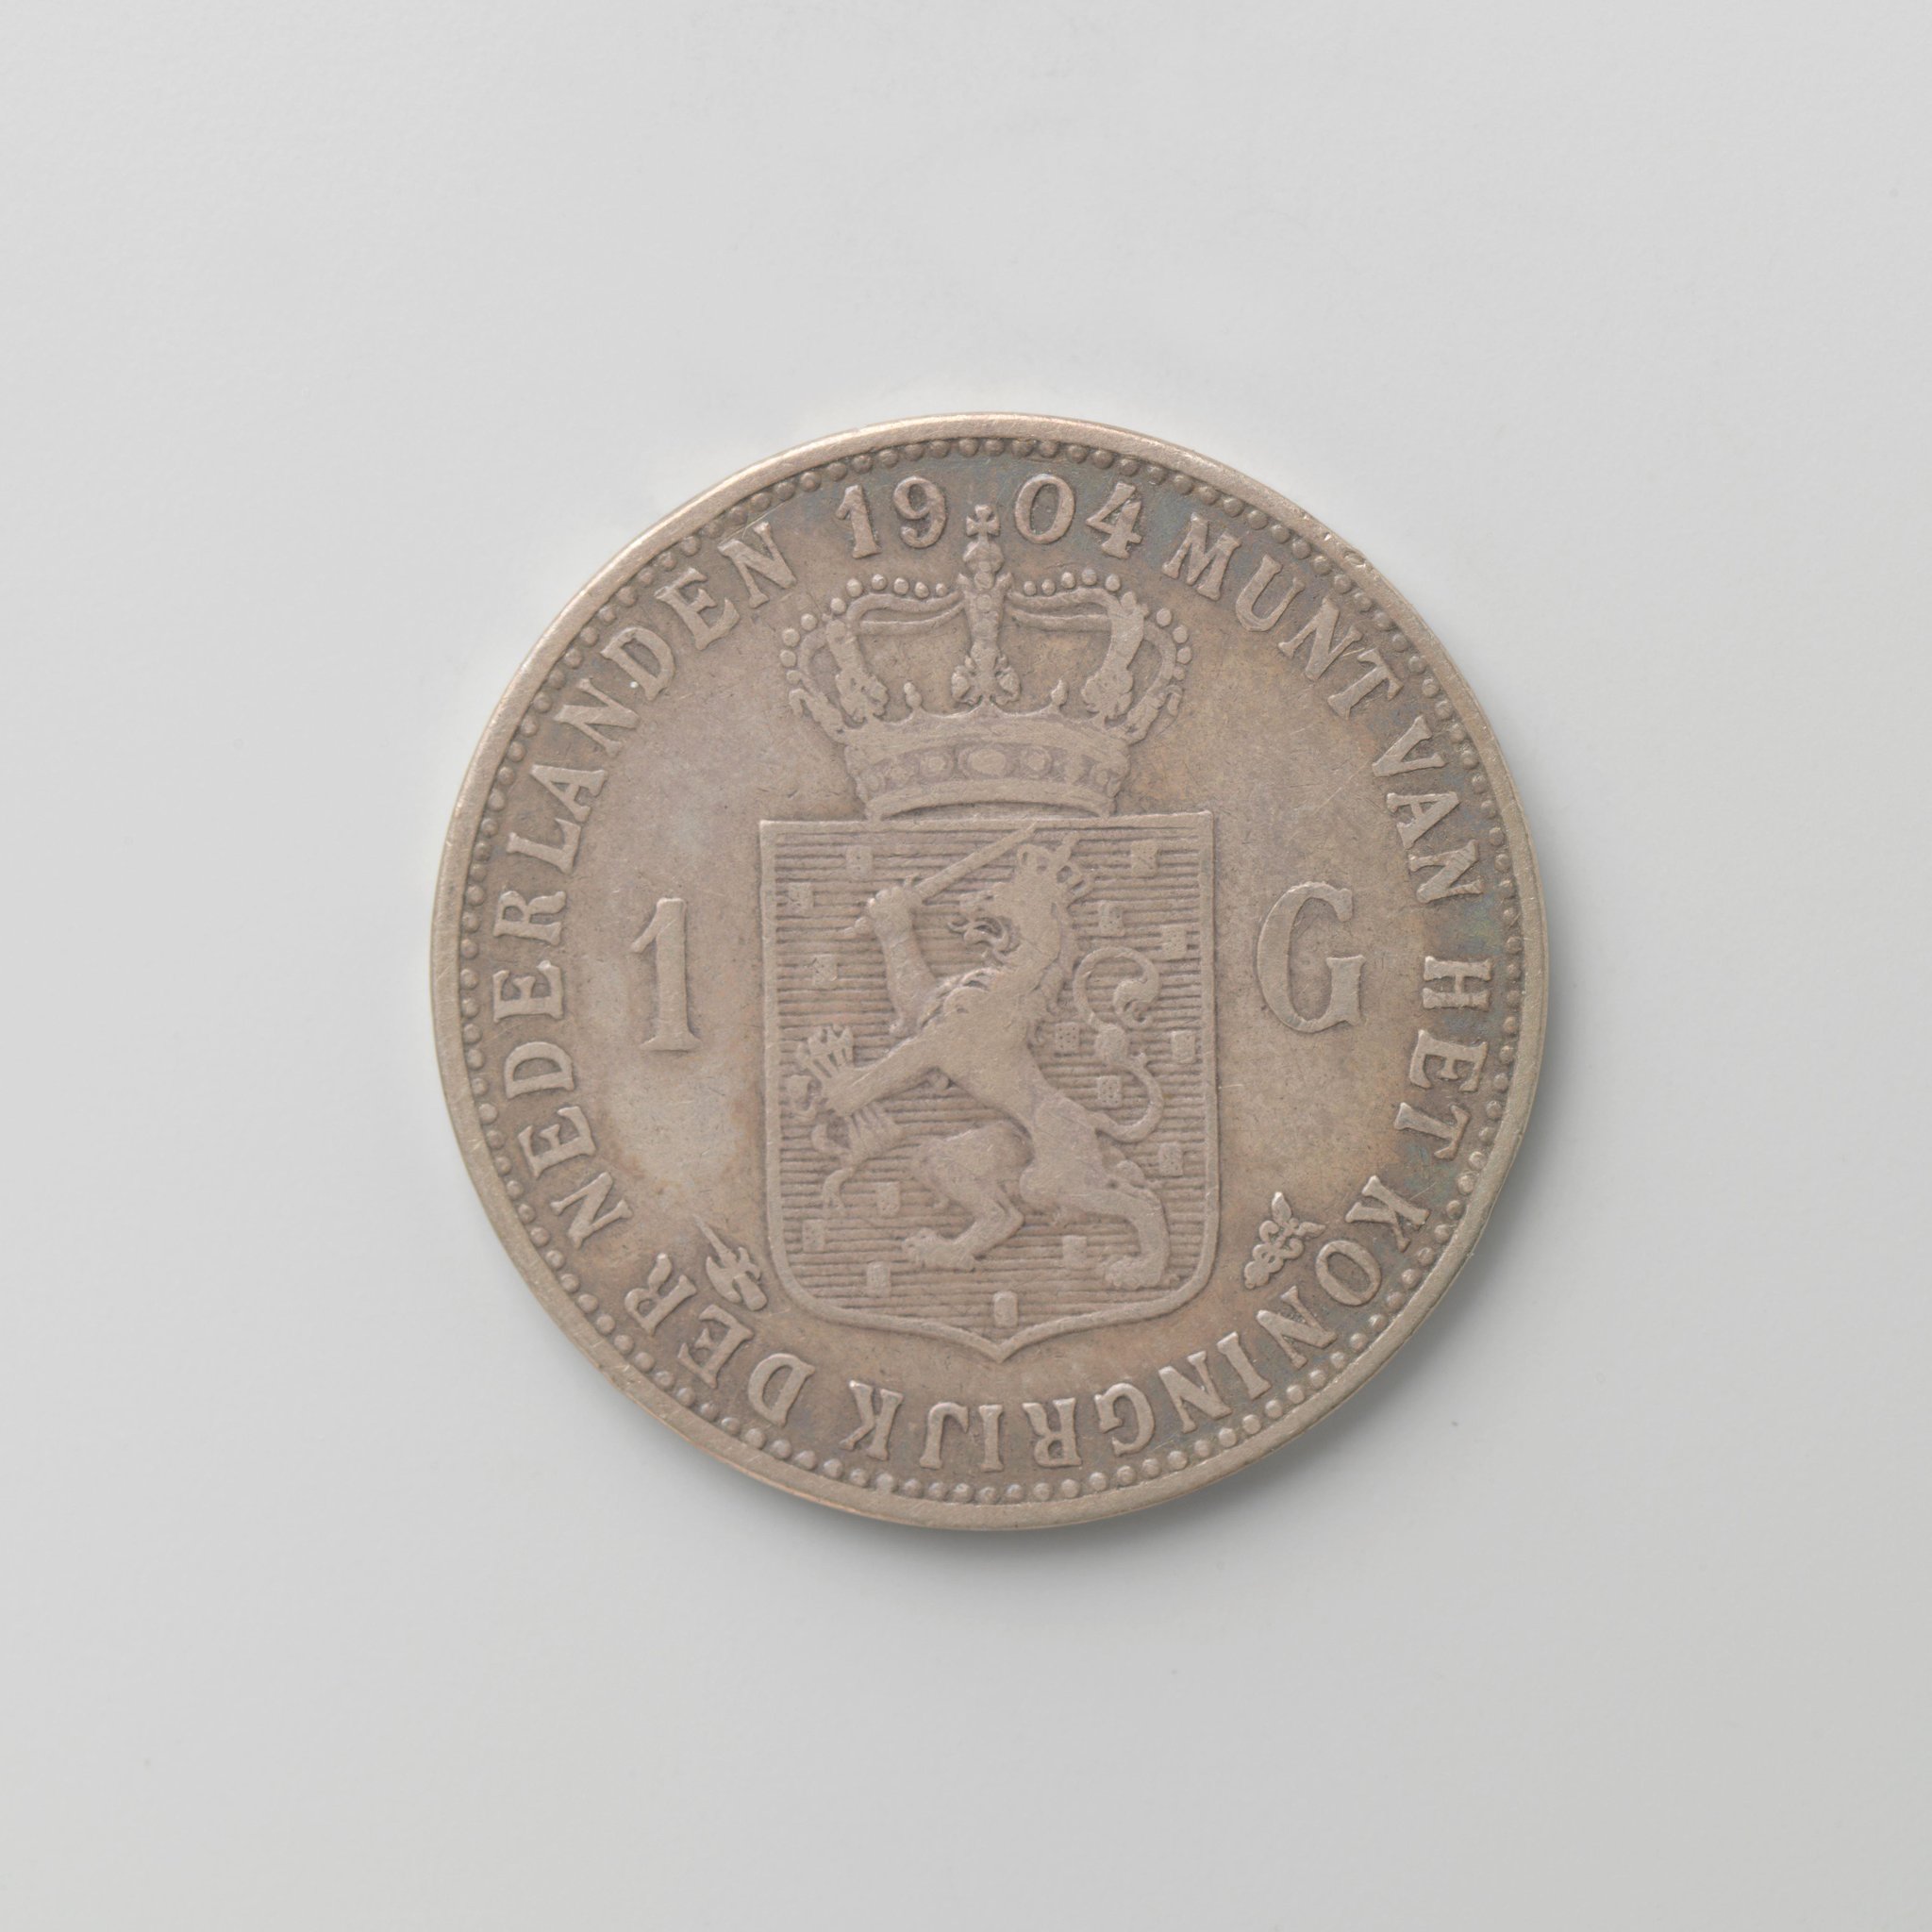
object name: coin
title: Nederlandse gulden,1904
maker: wilhelmina of the netherlands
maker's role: print maker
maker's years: 1880-1962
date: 1904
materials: silver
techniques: striking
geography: utrecht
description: Zilveren munt. Voorzijde: hoofd met diadeem naar links. Keerzijde: tussen waarde-aanduiding 1 G gekroond rijkswapenschild. Jaartal bovenaan in omschrift. Randschrift.